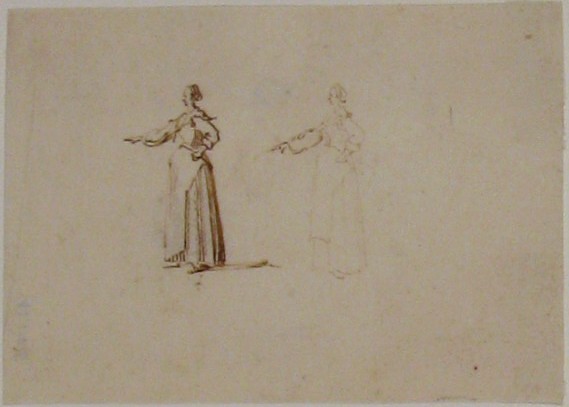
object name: drawing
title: A woman with hand outstretched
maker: jacques callot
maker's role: artist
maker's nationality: french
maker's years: 1592-1635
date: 1601-1633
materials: ink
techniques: pen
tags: women